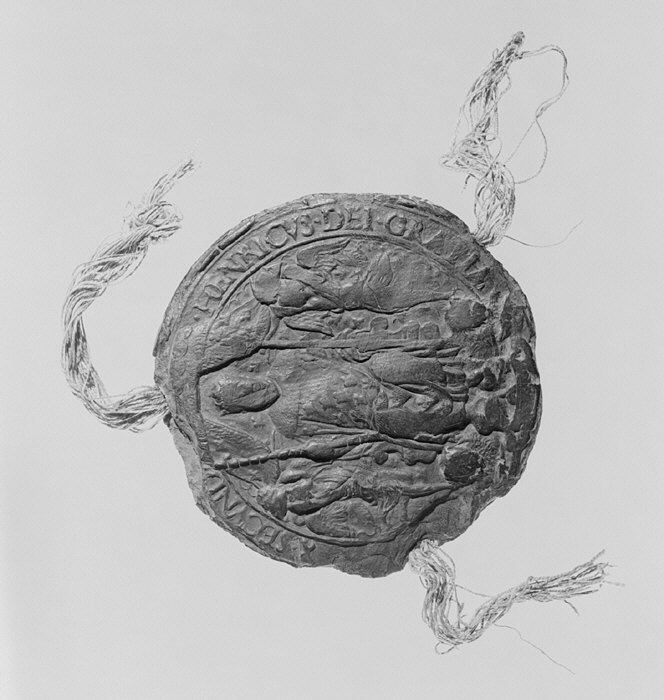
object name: seal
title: Royal Seal of Henri II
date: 1547-1559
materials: silk, wax